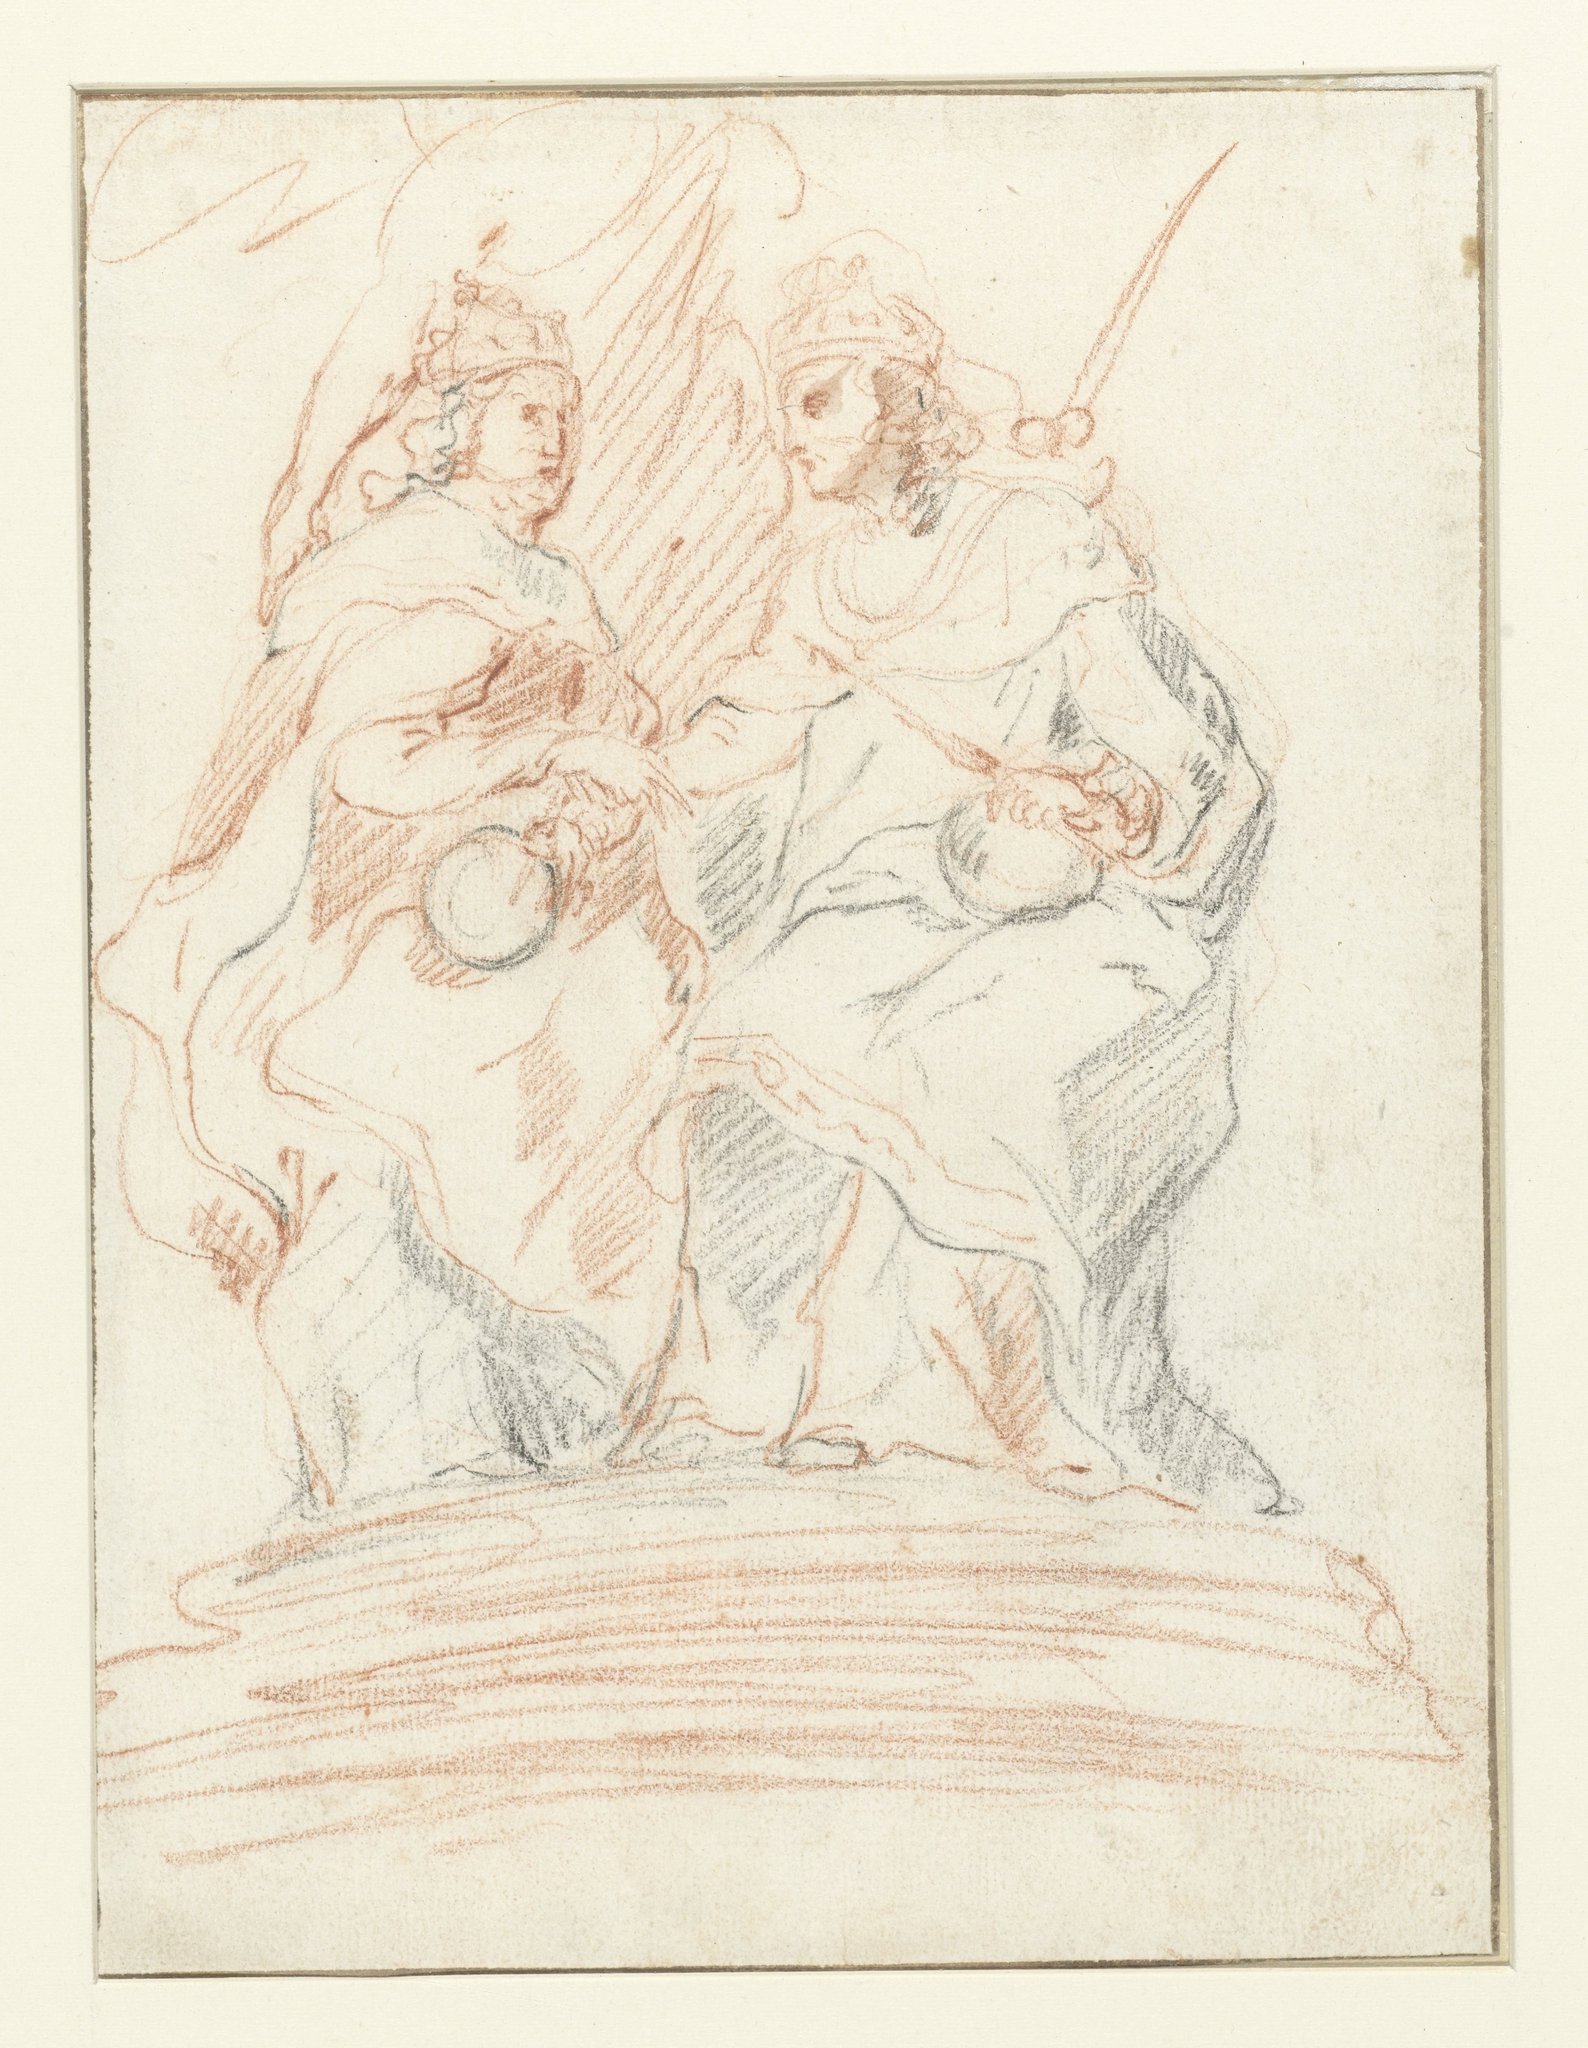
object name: drawing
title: Koning en een koningin op een troon, achter hen staat Fama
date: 1700-1800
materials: chalk, paper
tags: fame; 'fama', 'fama buona', 'fama chiara' (ripa) (+ abstract concept represented by female figure), queen, king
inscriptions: annotation, pencil: ‘Legaat De Witte / v. Citters’, annotation, pencil: ‘P. P. Rubens’